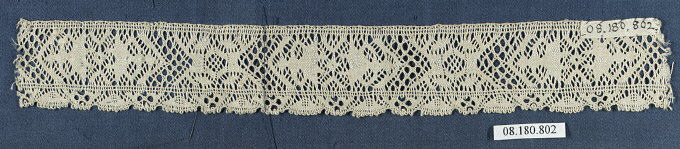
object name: fragment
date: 1701-1800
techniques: lace